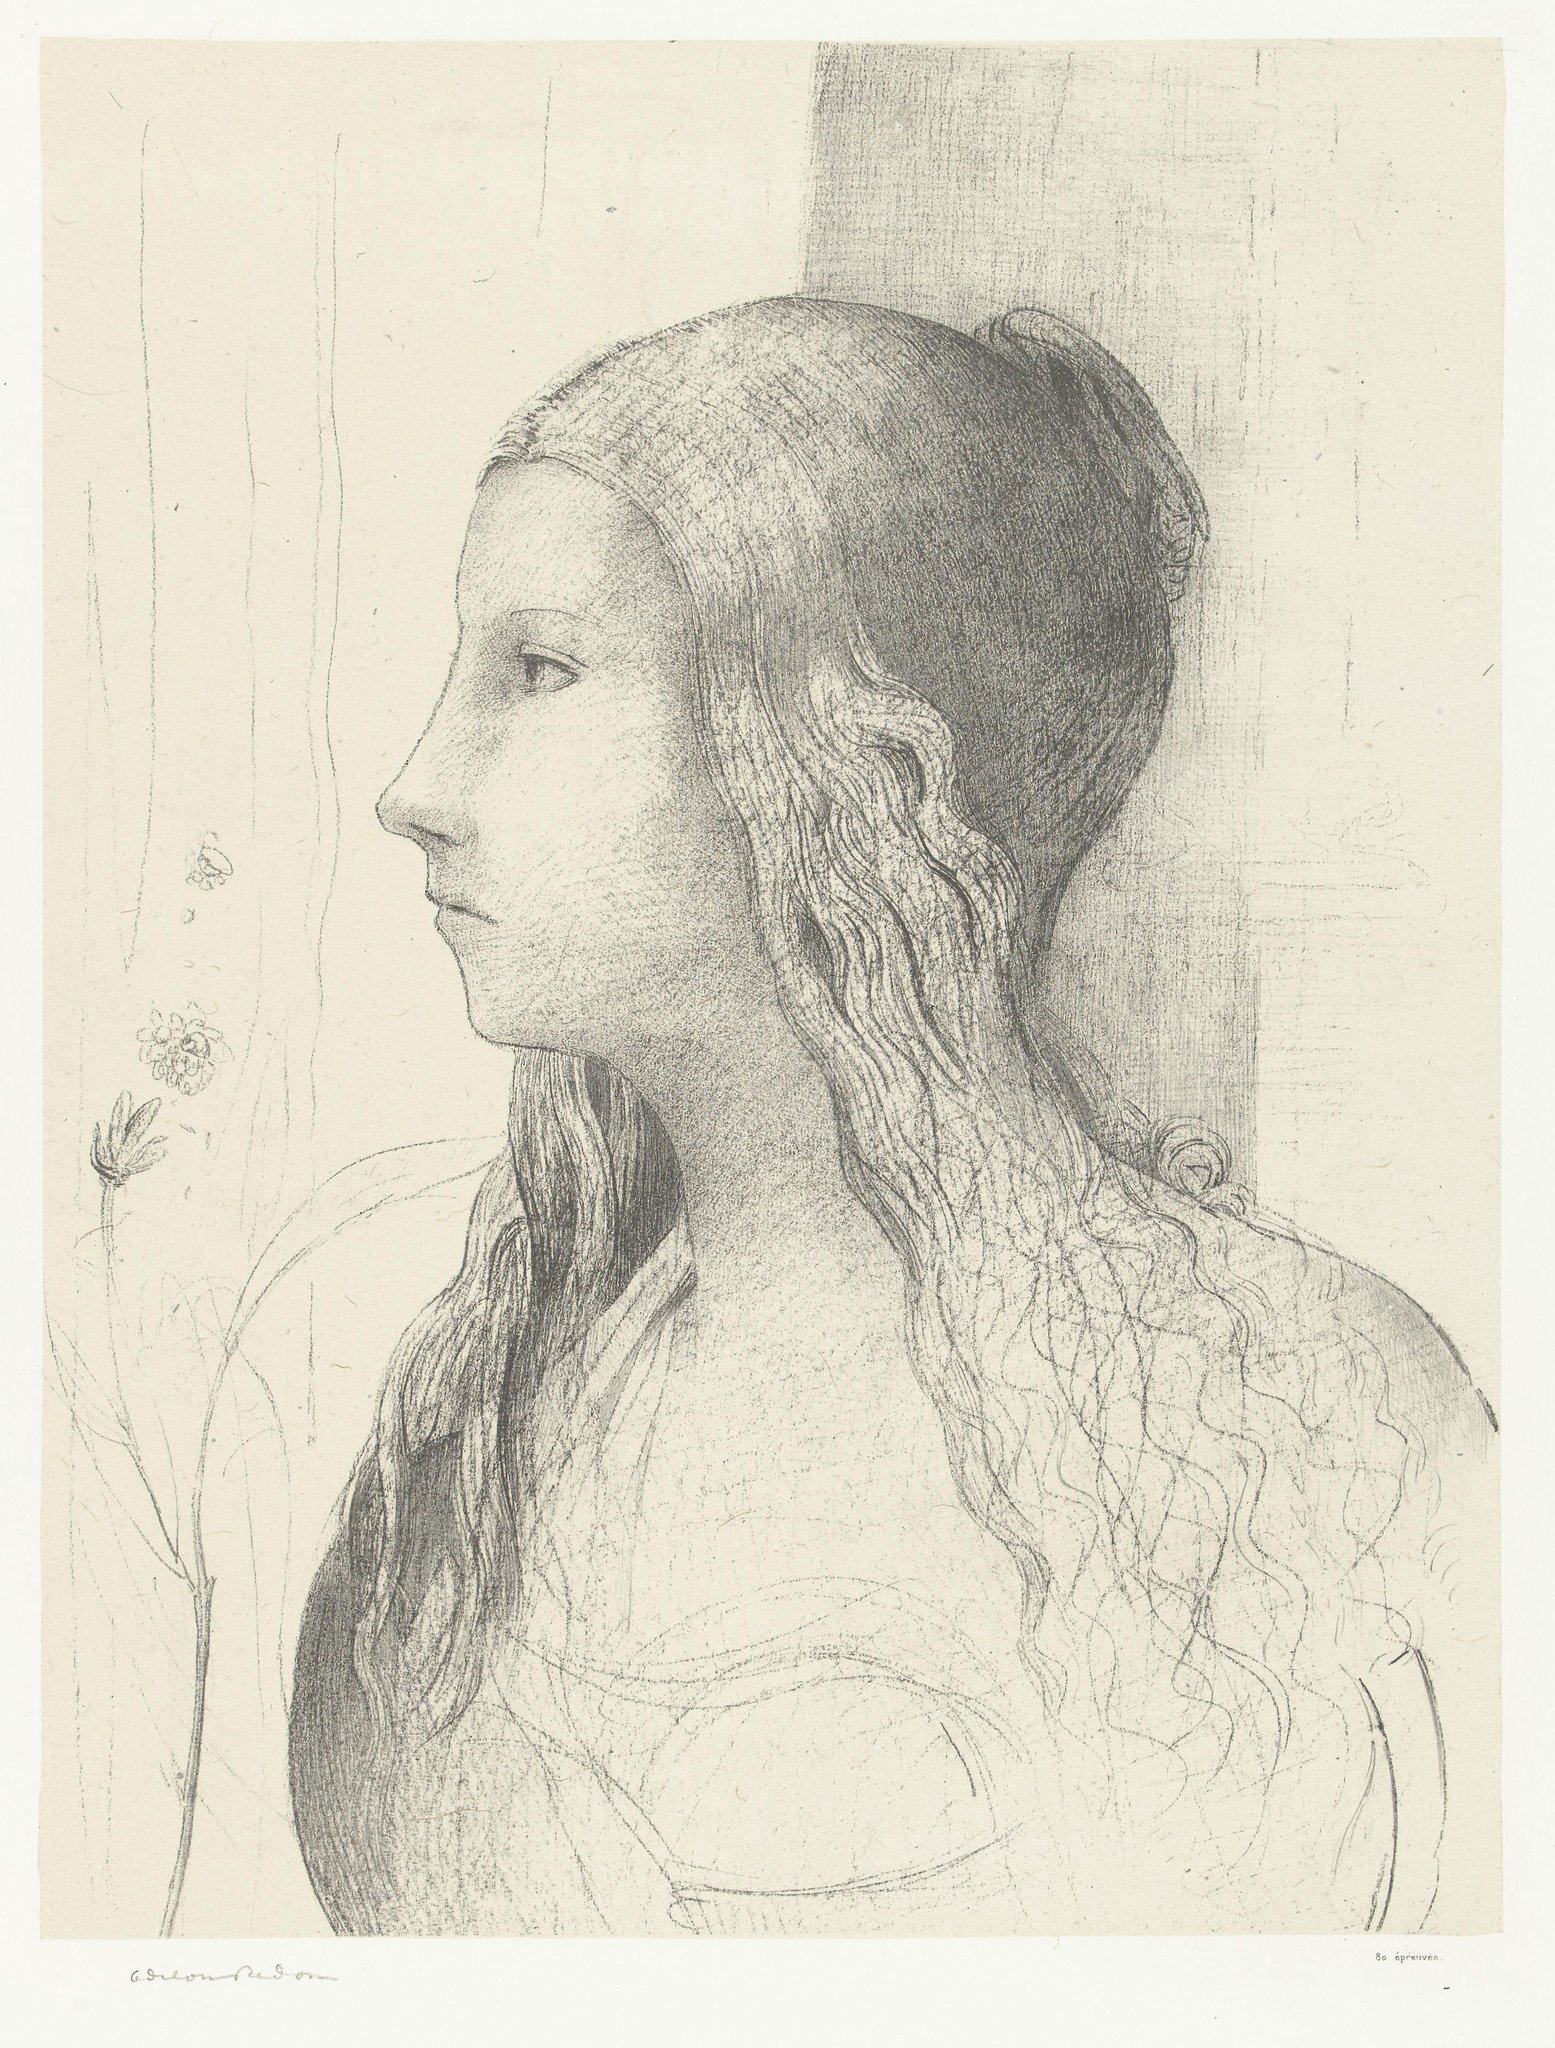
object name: print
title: Brunhilde (ondergang van de Goden)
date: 1894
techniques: printmaking, lithograph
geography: paris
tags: brunhild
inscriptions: collector's mark: Lugt 2228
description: Brunhilde, een vrouw uit de Noorse mythologie, en profil.